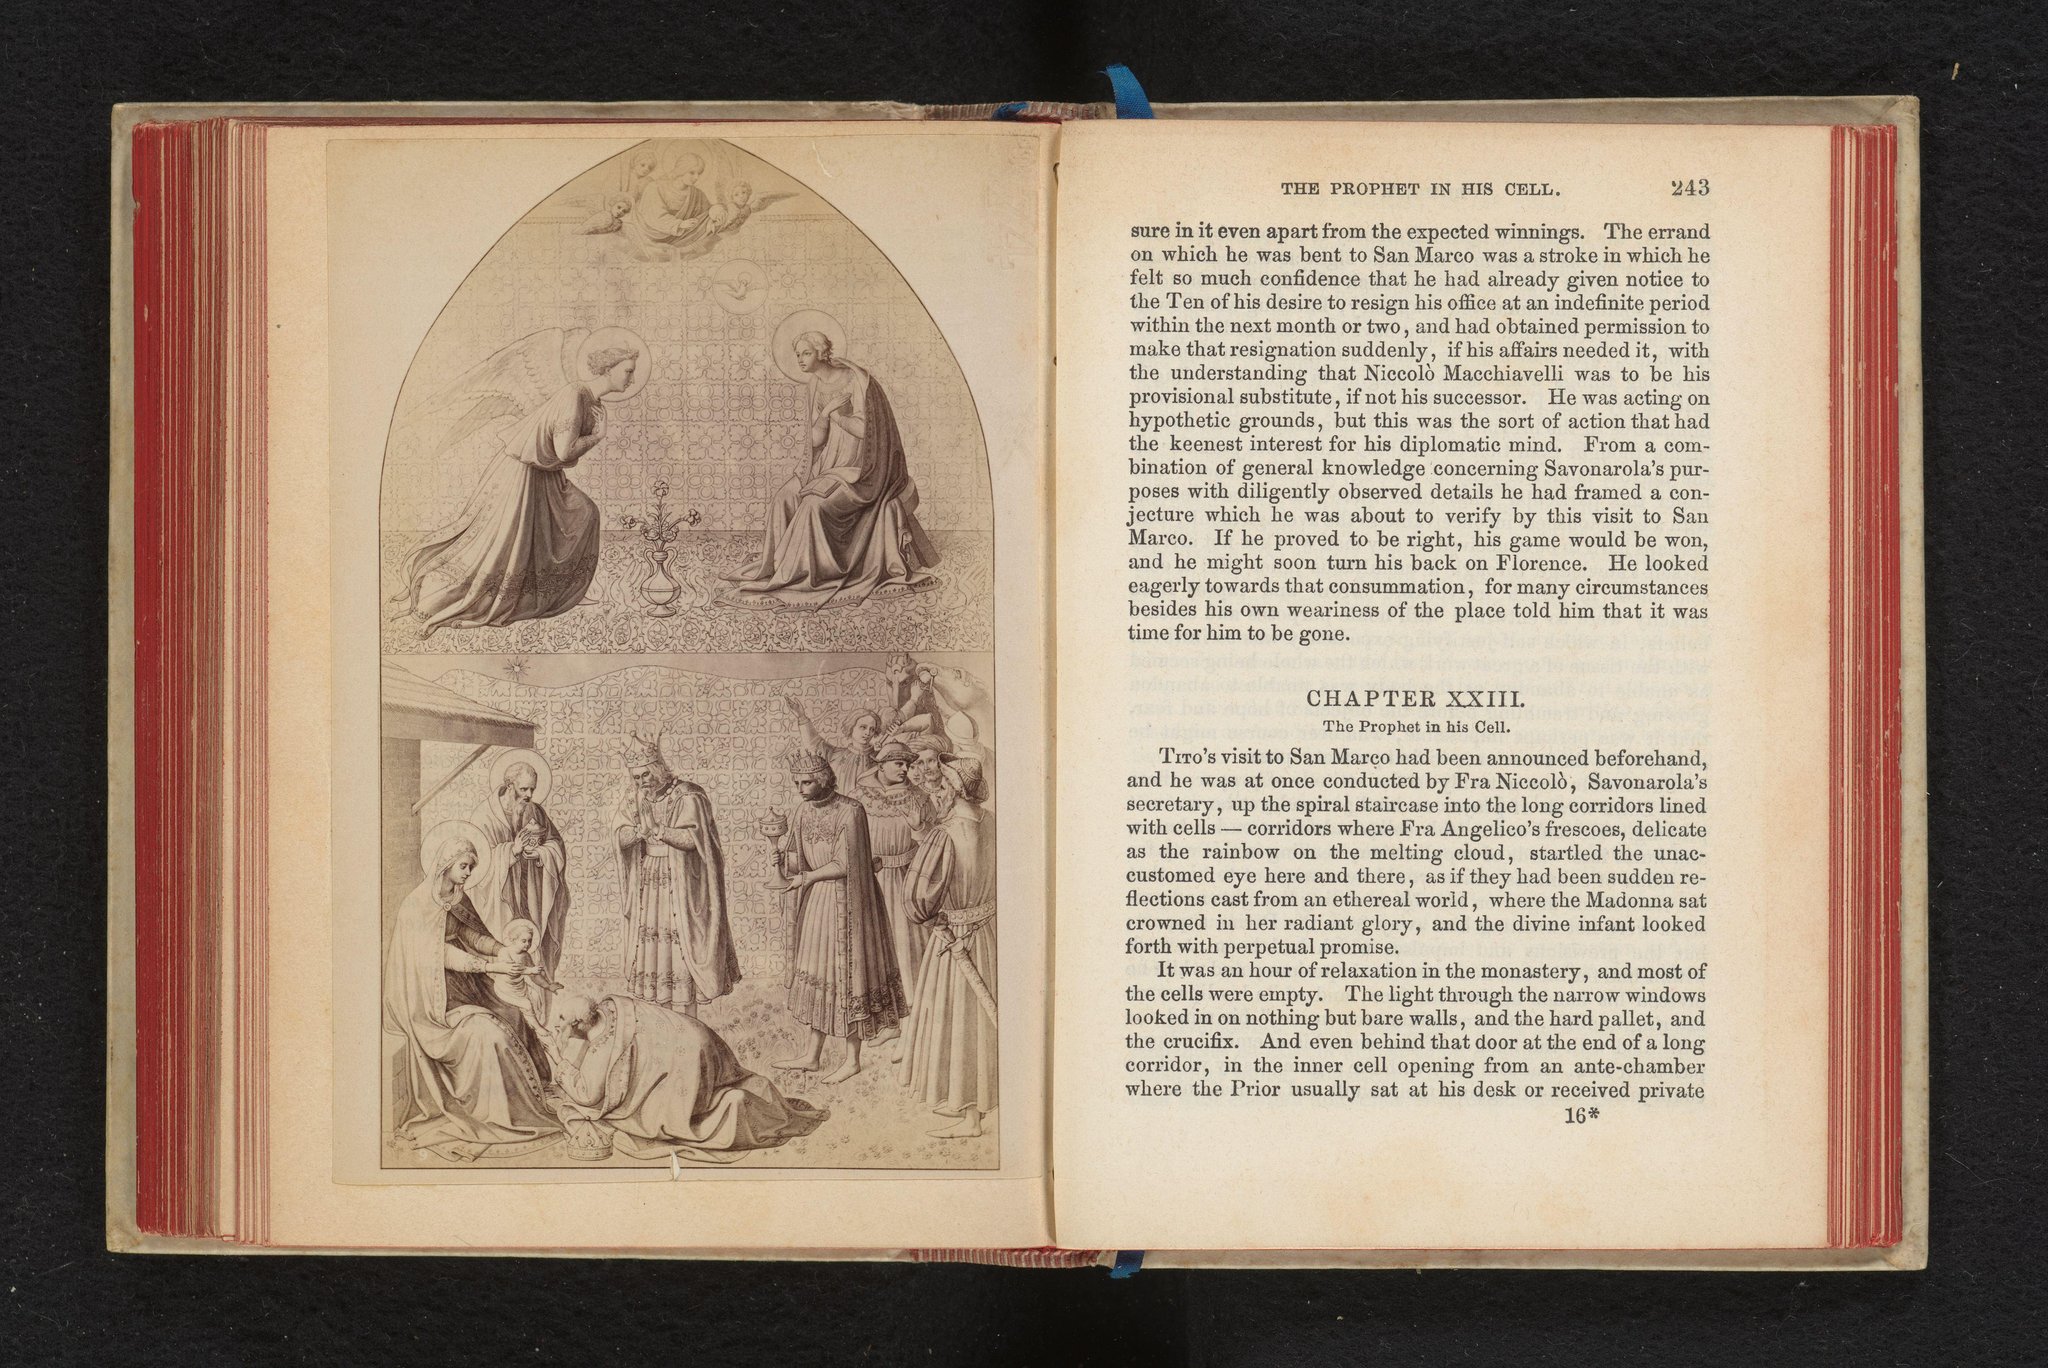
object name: reproduction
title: Fotoreproductie van een prent naar een fresco door Fra Angelico van de annunciatie en de aanbidding van het Christuskind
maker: giacomo brogi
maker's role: fotograaf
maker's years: 1822-1881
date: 1858-1863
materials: paper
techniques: albumen print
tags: adoration of the kings: the wise men present their gifts to the christ-child (gold, frankincense and myrrh), the annunciation: mary sitting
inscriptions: name: ‘Brogi’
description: Foto op ongenummerde pagina tegenover pagina 243.